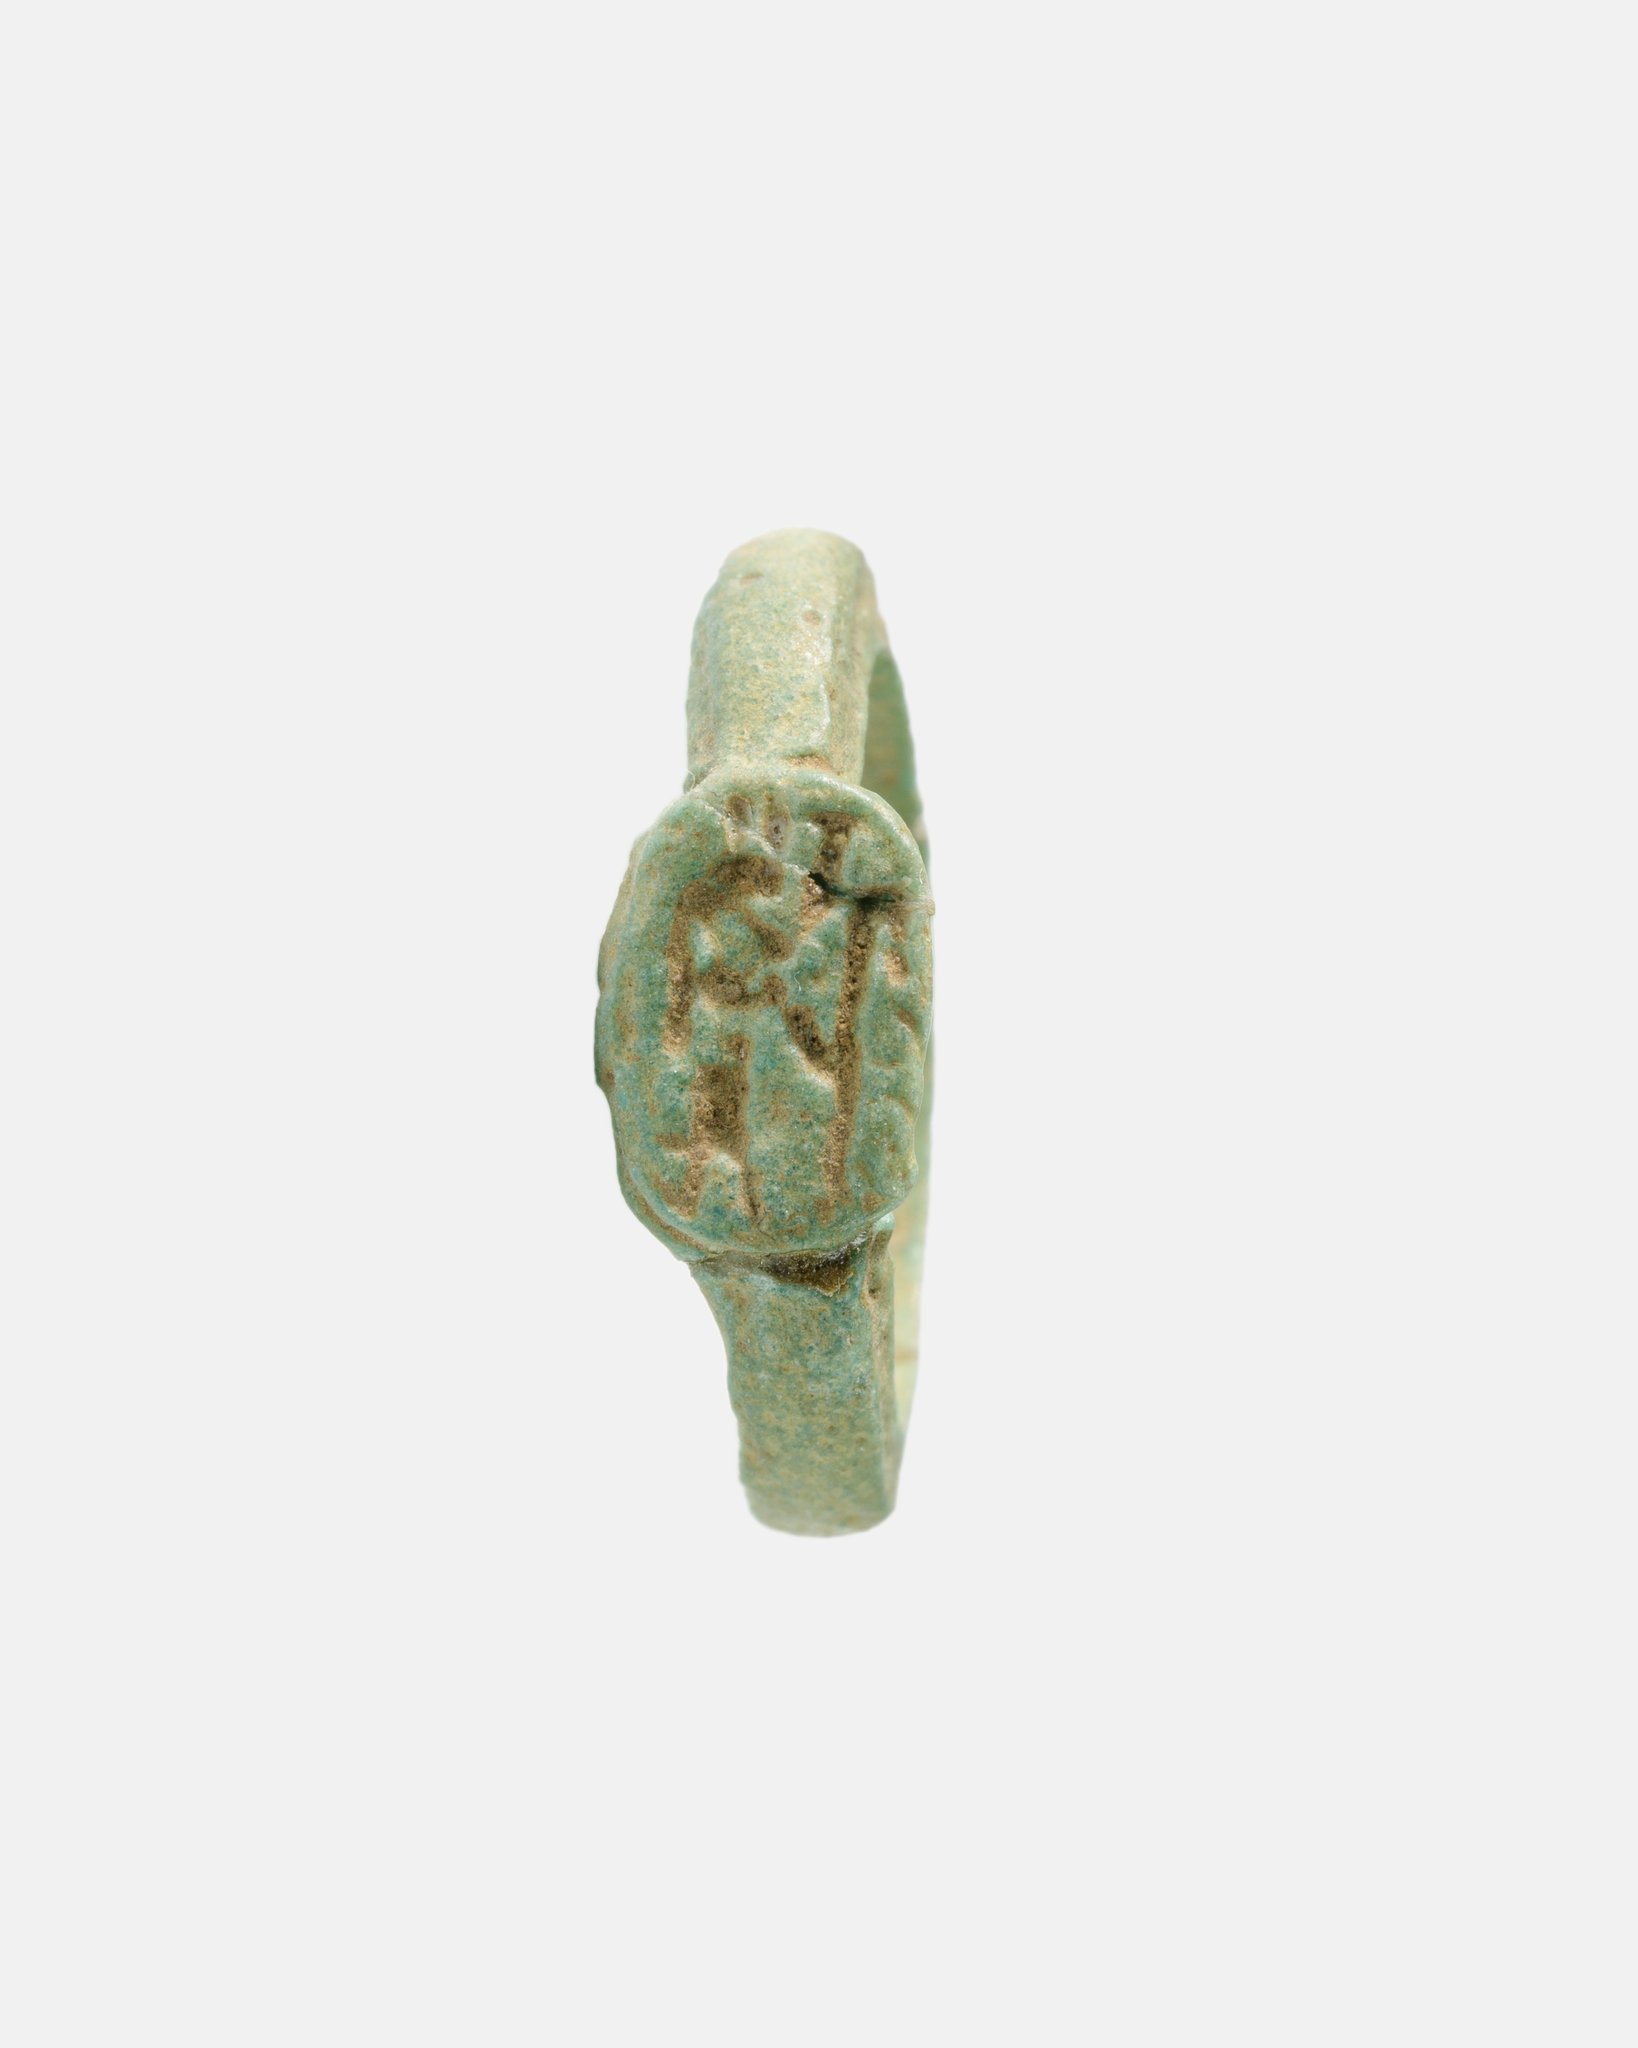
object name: ring, god figure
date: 1295-1070 BCE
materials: faience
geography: northern upper egypt